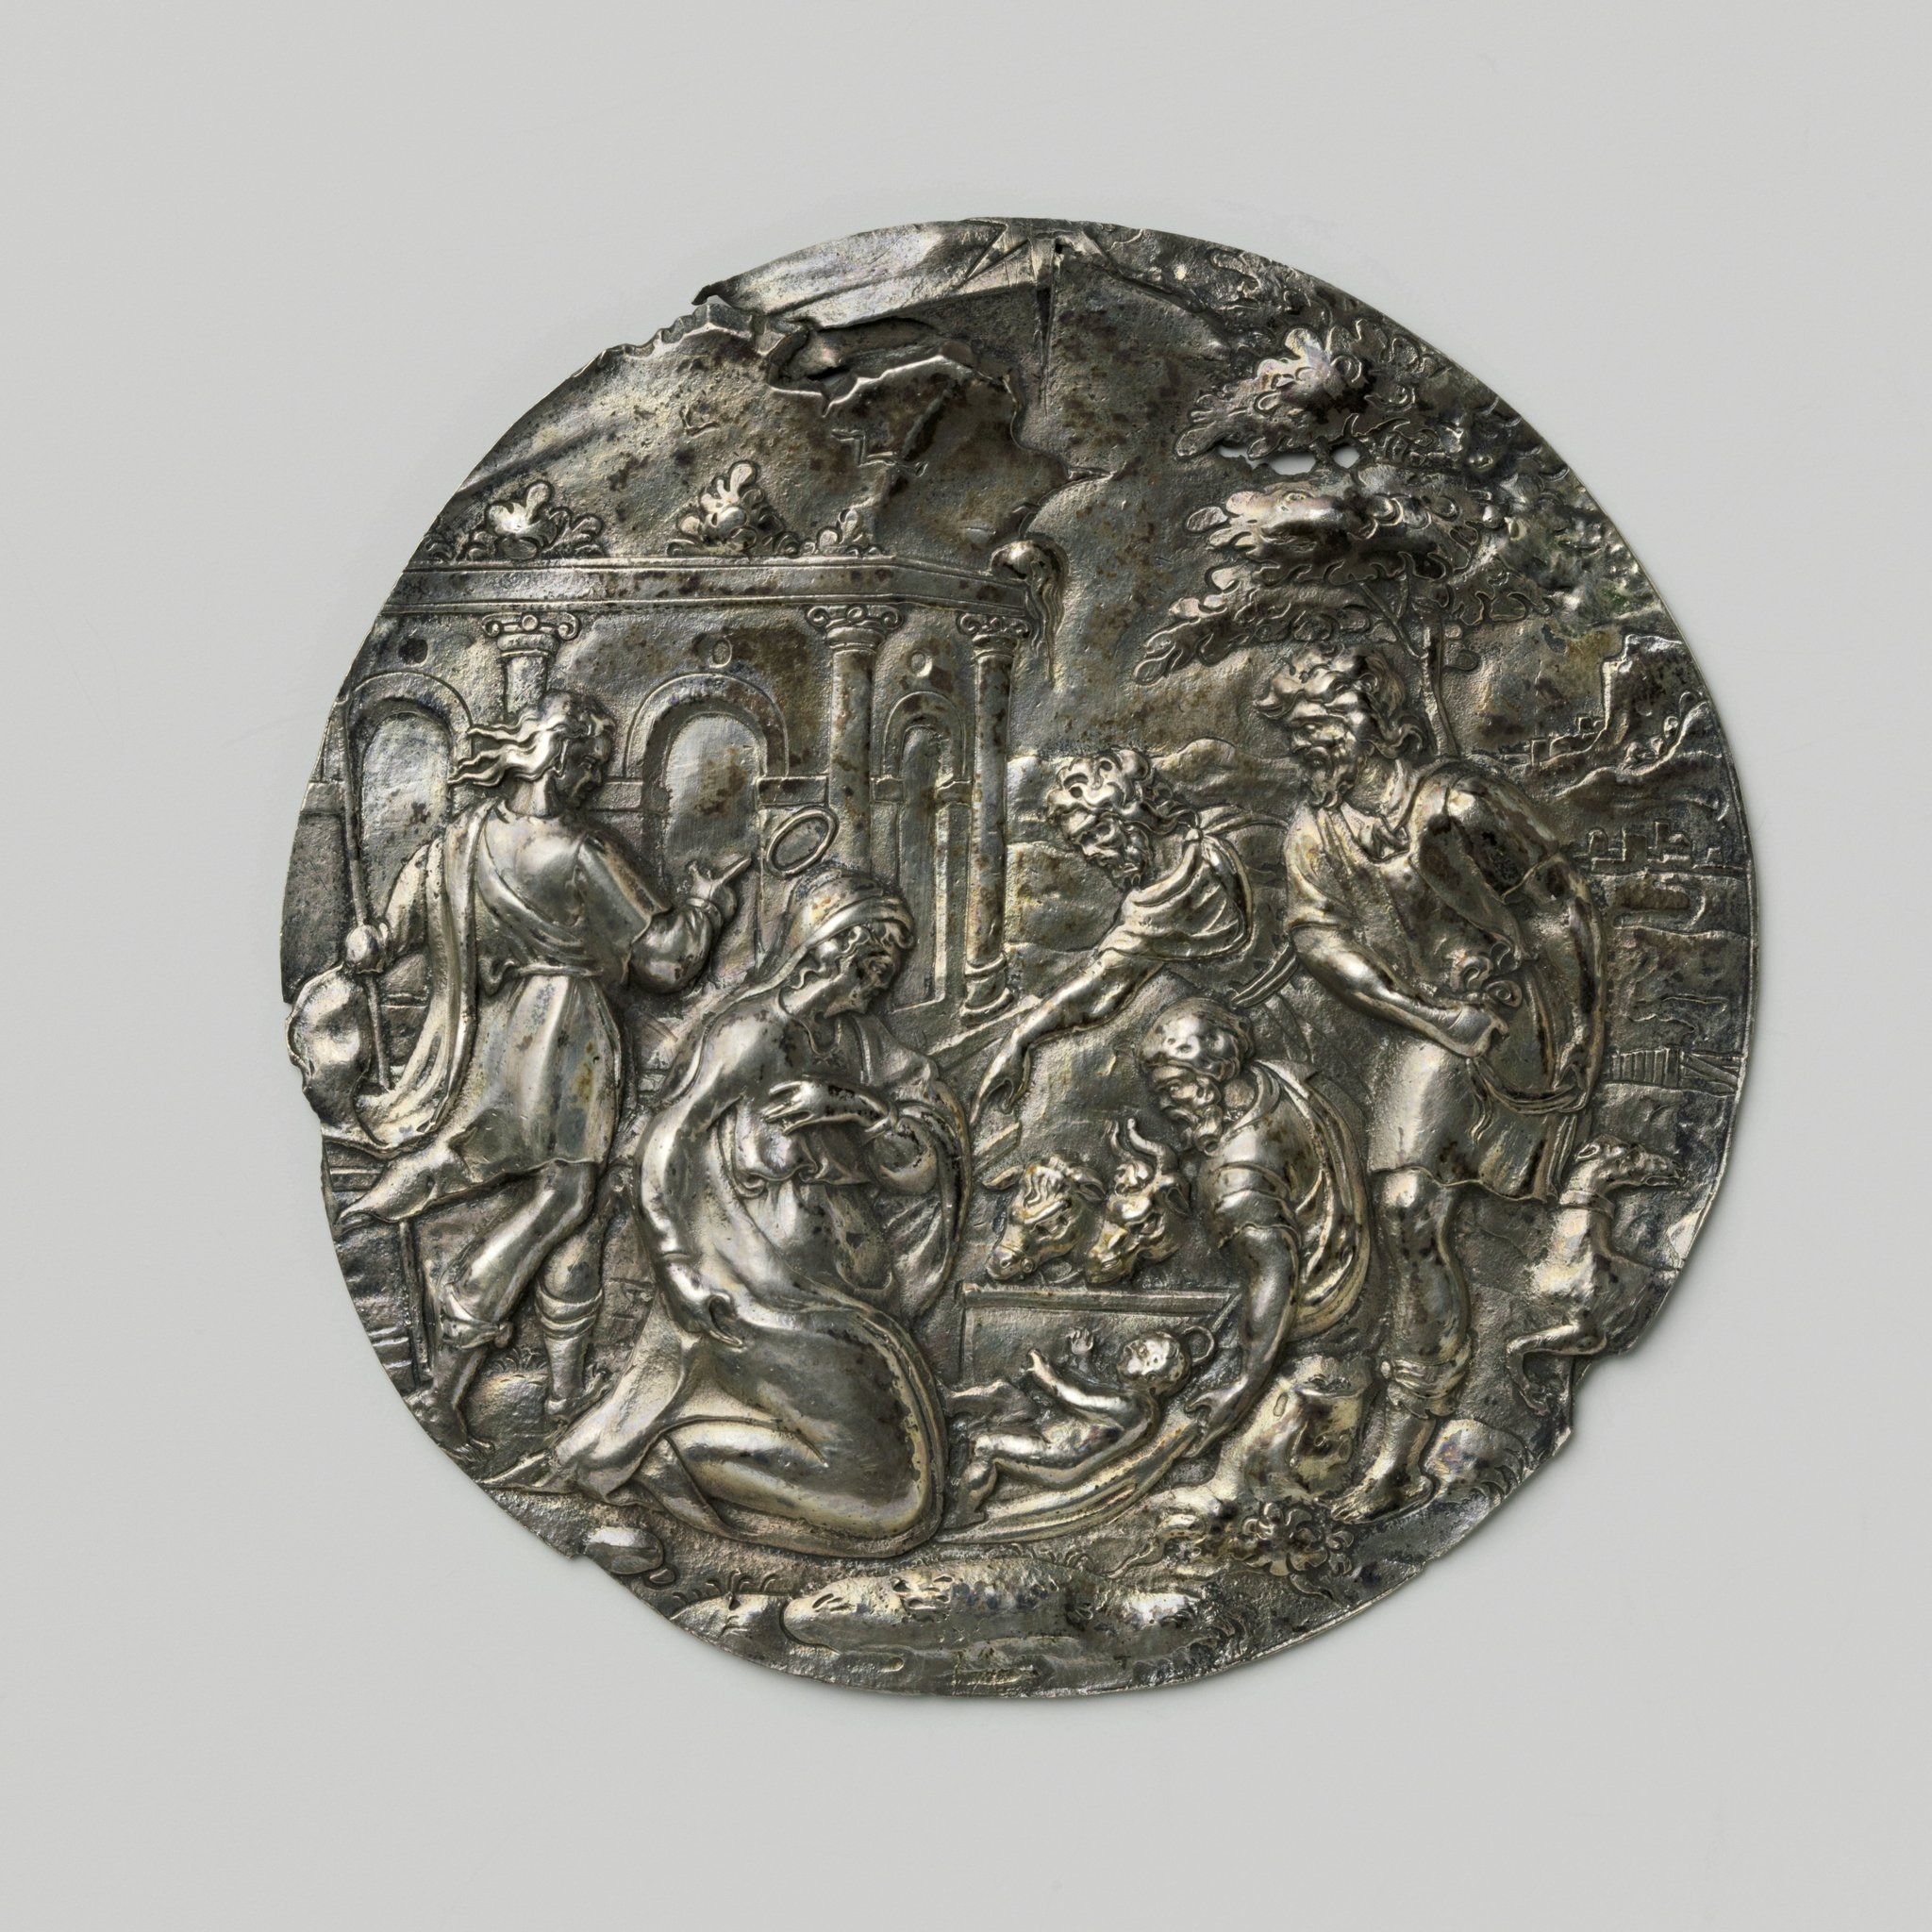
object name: plaque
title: Aanbidding der herders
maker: Anonymous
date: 1625-1650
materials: silver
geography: netherlands